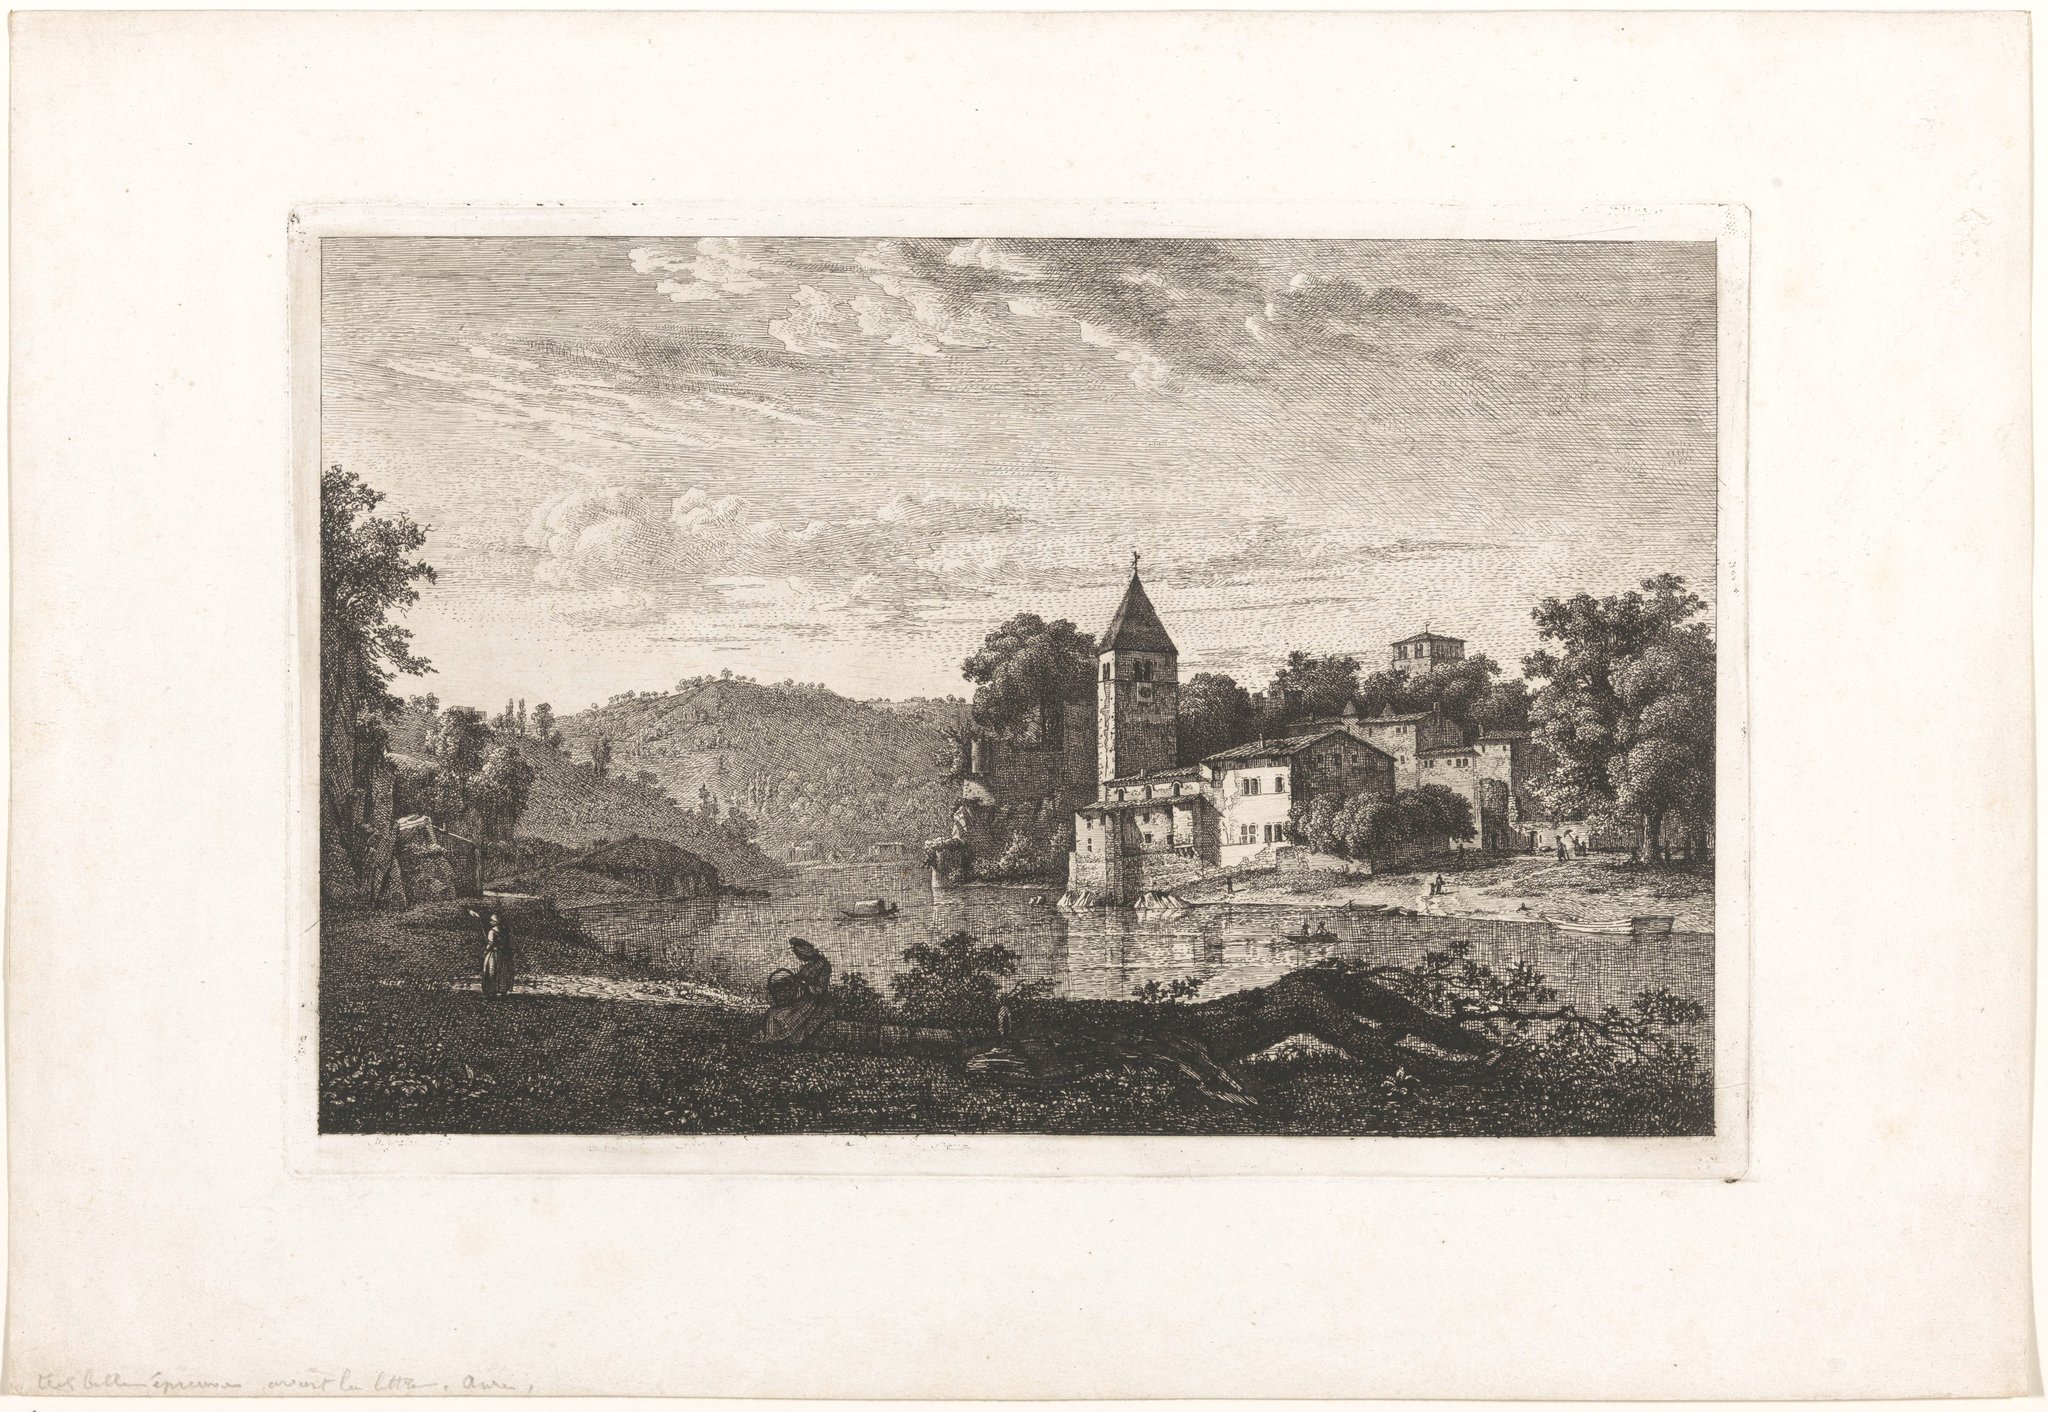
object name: print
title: Gezicht op het eiland Barbe in de Saône rivier, met de Romaanse Onze-Lieve-Vrouwe kerk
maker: jean-michel grobon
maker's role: draughtsman, painter, print maker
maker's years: 1770-1853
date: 1790-1810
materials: paper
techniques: engraving, etching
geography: lyon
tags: river, church (exterior)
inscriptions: collector's mark: Lugt 2760, inscription: ‘Tres belle épreuve avant la lettre’, collector's mark: Lugt 2228